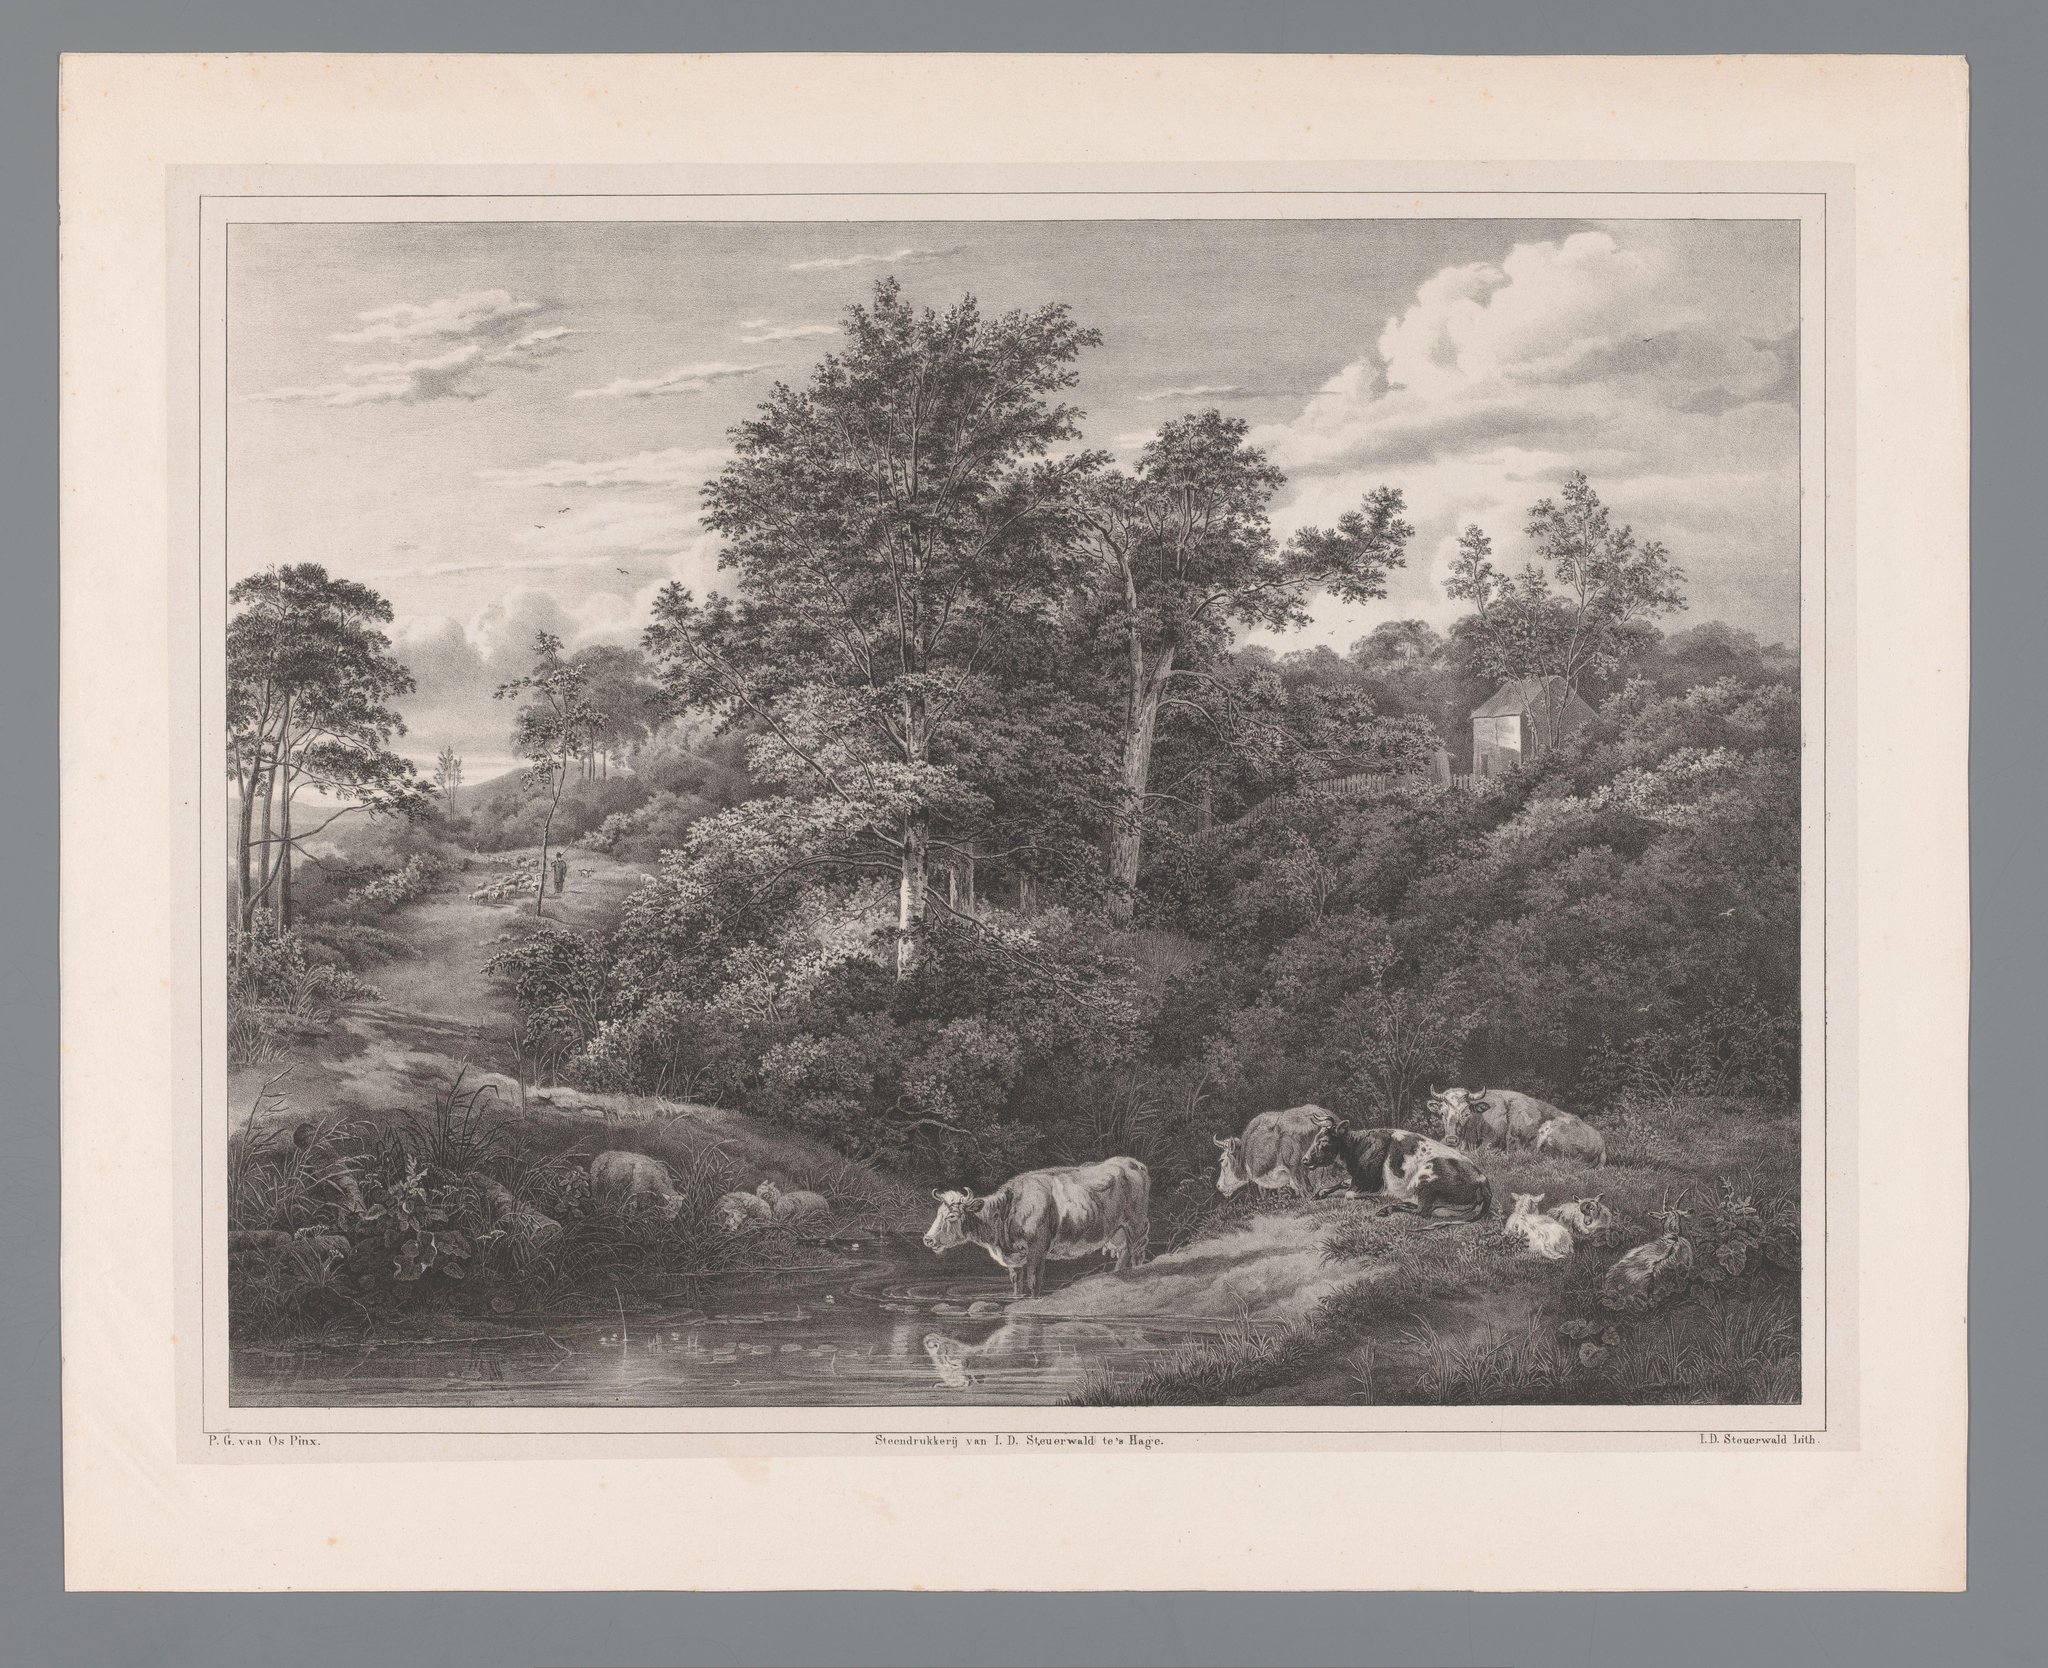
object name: print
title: Landschap met koeien aan het water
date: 1833-1863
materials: paper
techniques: lithograph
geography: the hague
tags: cow, landscapes (+ landscape with figures, staffage)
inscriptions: collector's mark: Lugt 2165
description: Gezien het afwijkende onderschrift en de vervaardiger maakt de prent vermoedelijk geen deel uit van de serie Schilderijen van Nederlandsche meesters uit de verzameling van Wijlen den Wel-Ed. Geb. Heer J.A. van Dam (1829).